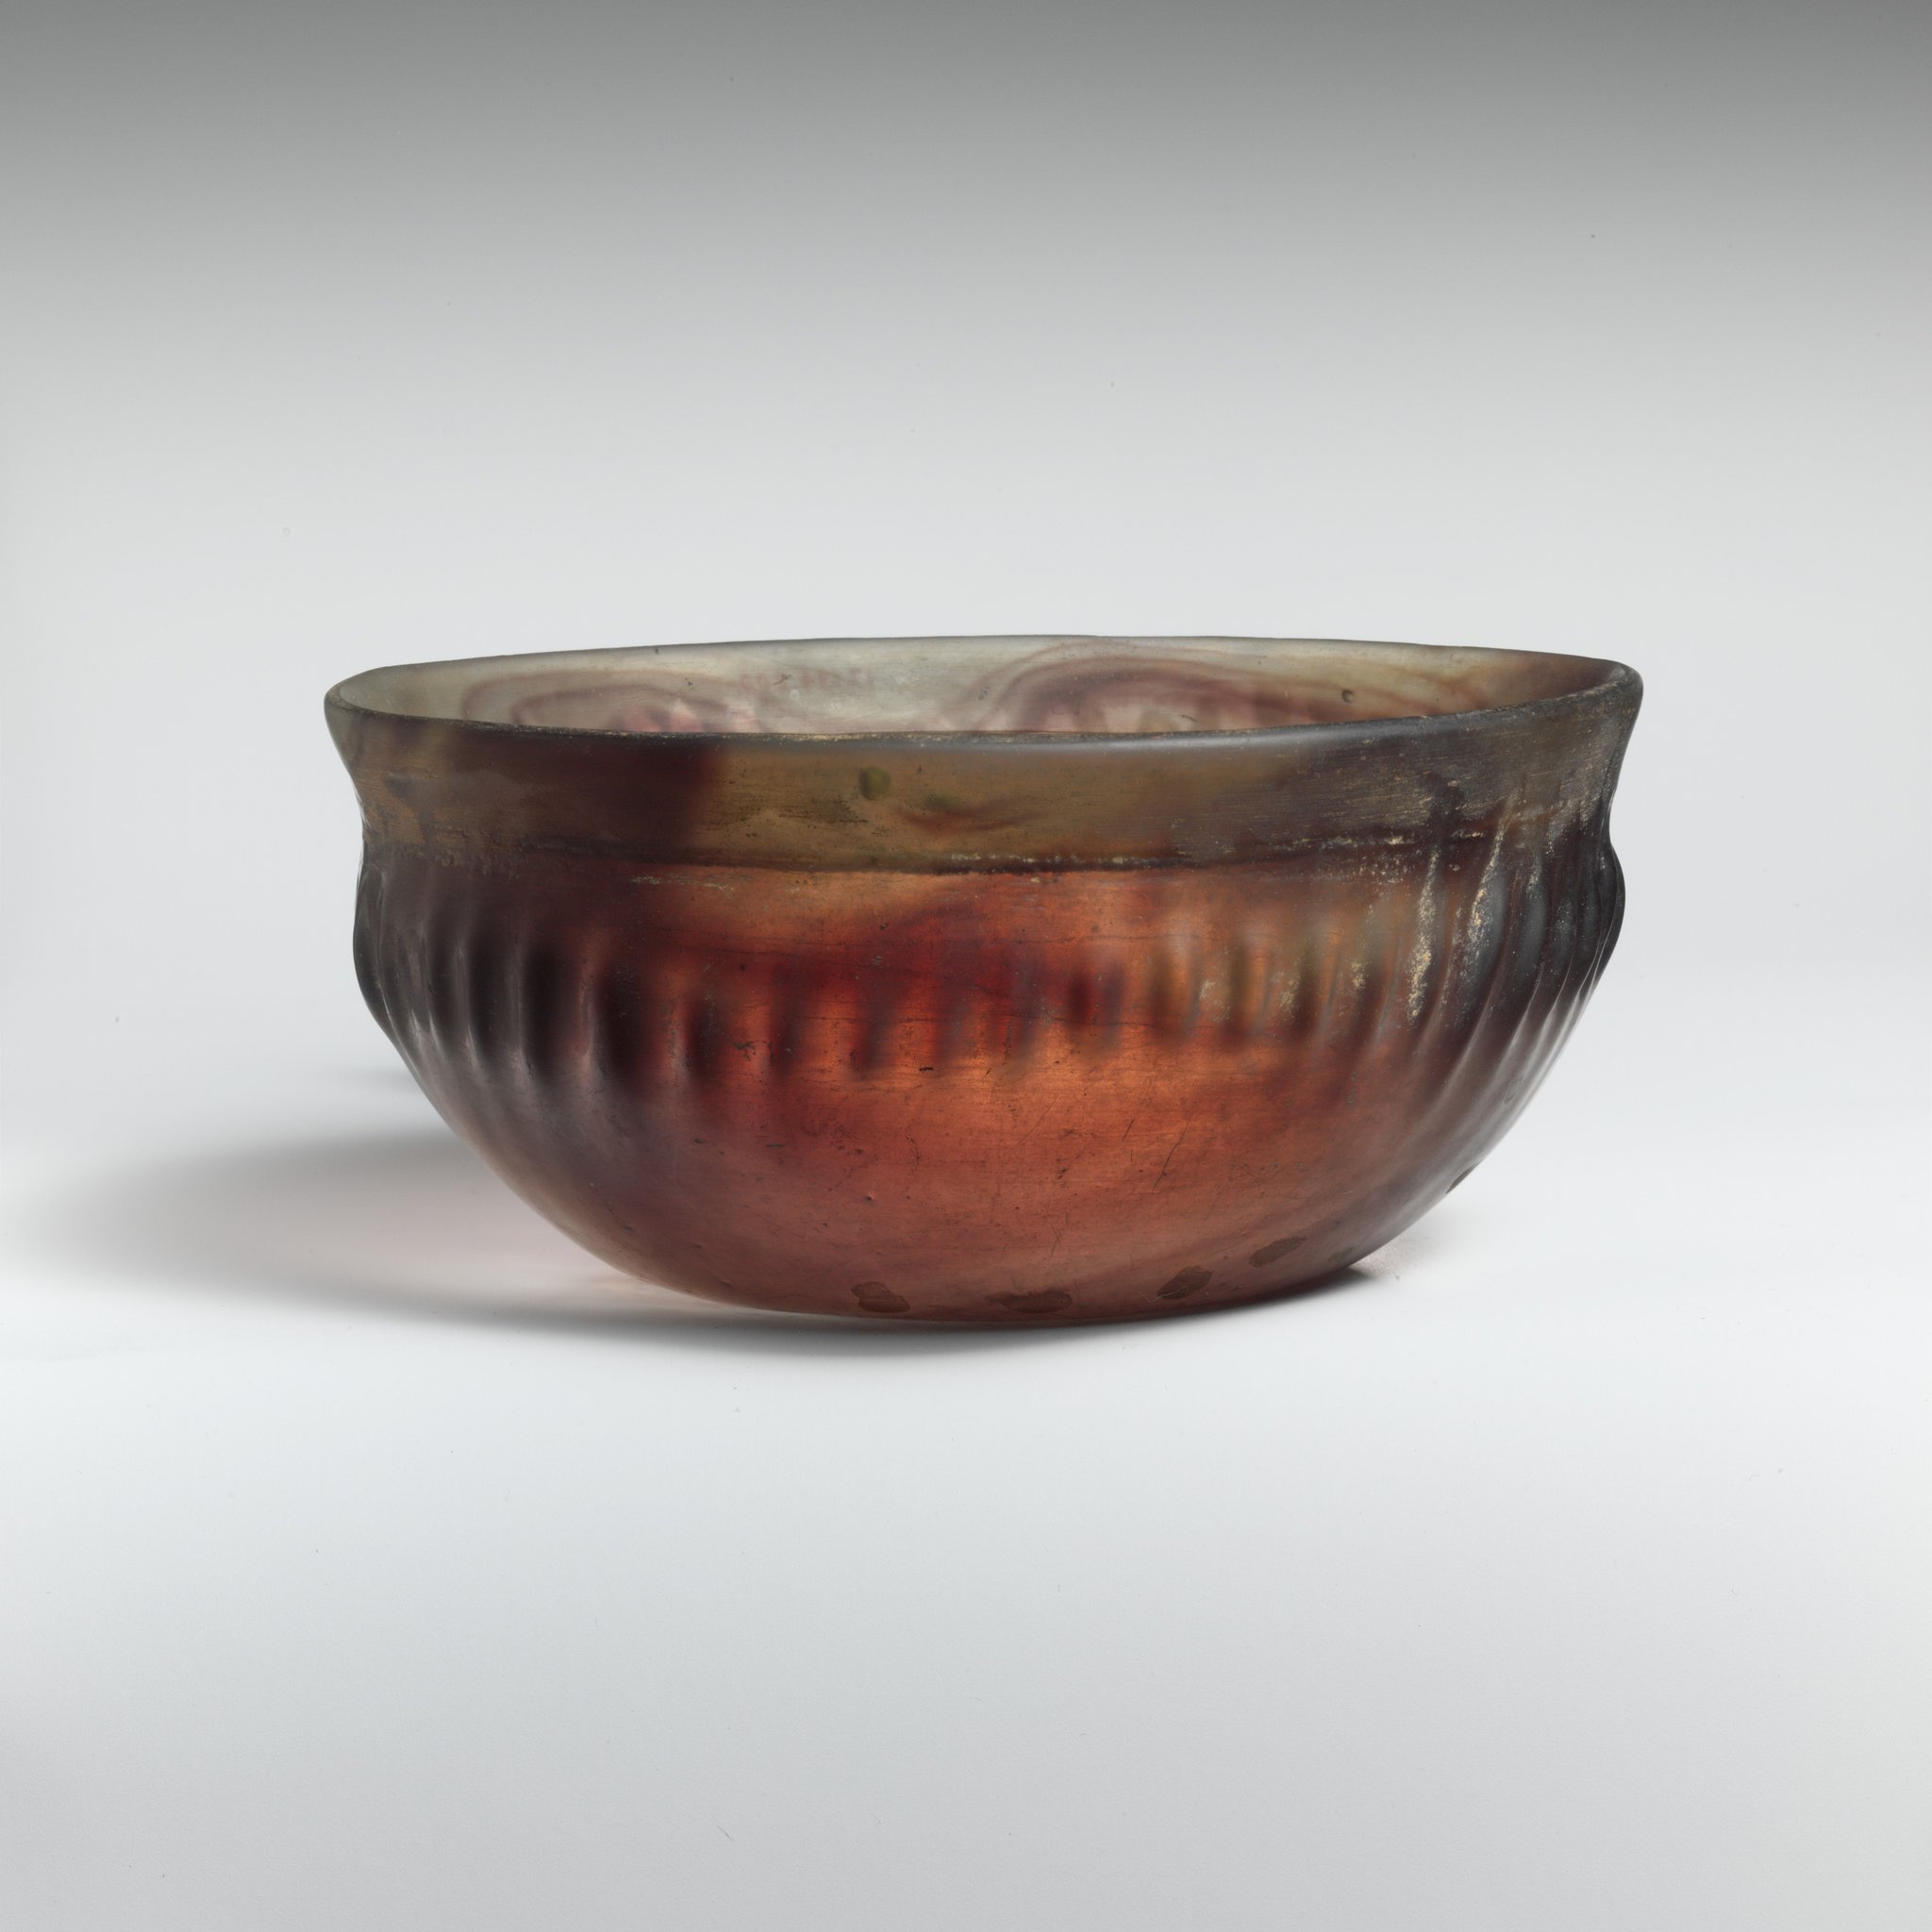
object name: bowl, ribbed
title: Glass ribbed bowl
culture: roman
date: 67-100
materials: glass